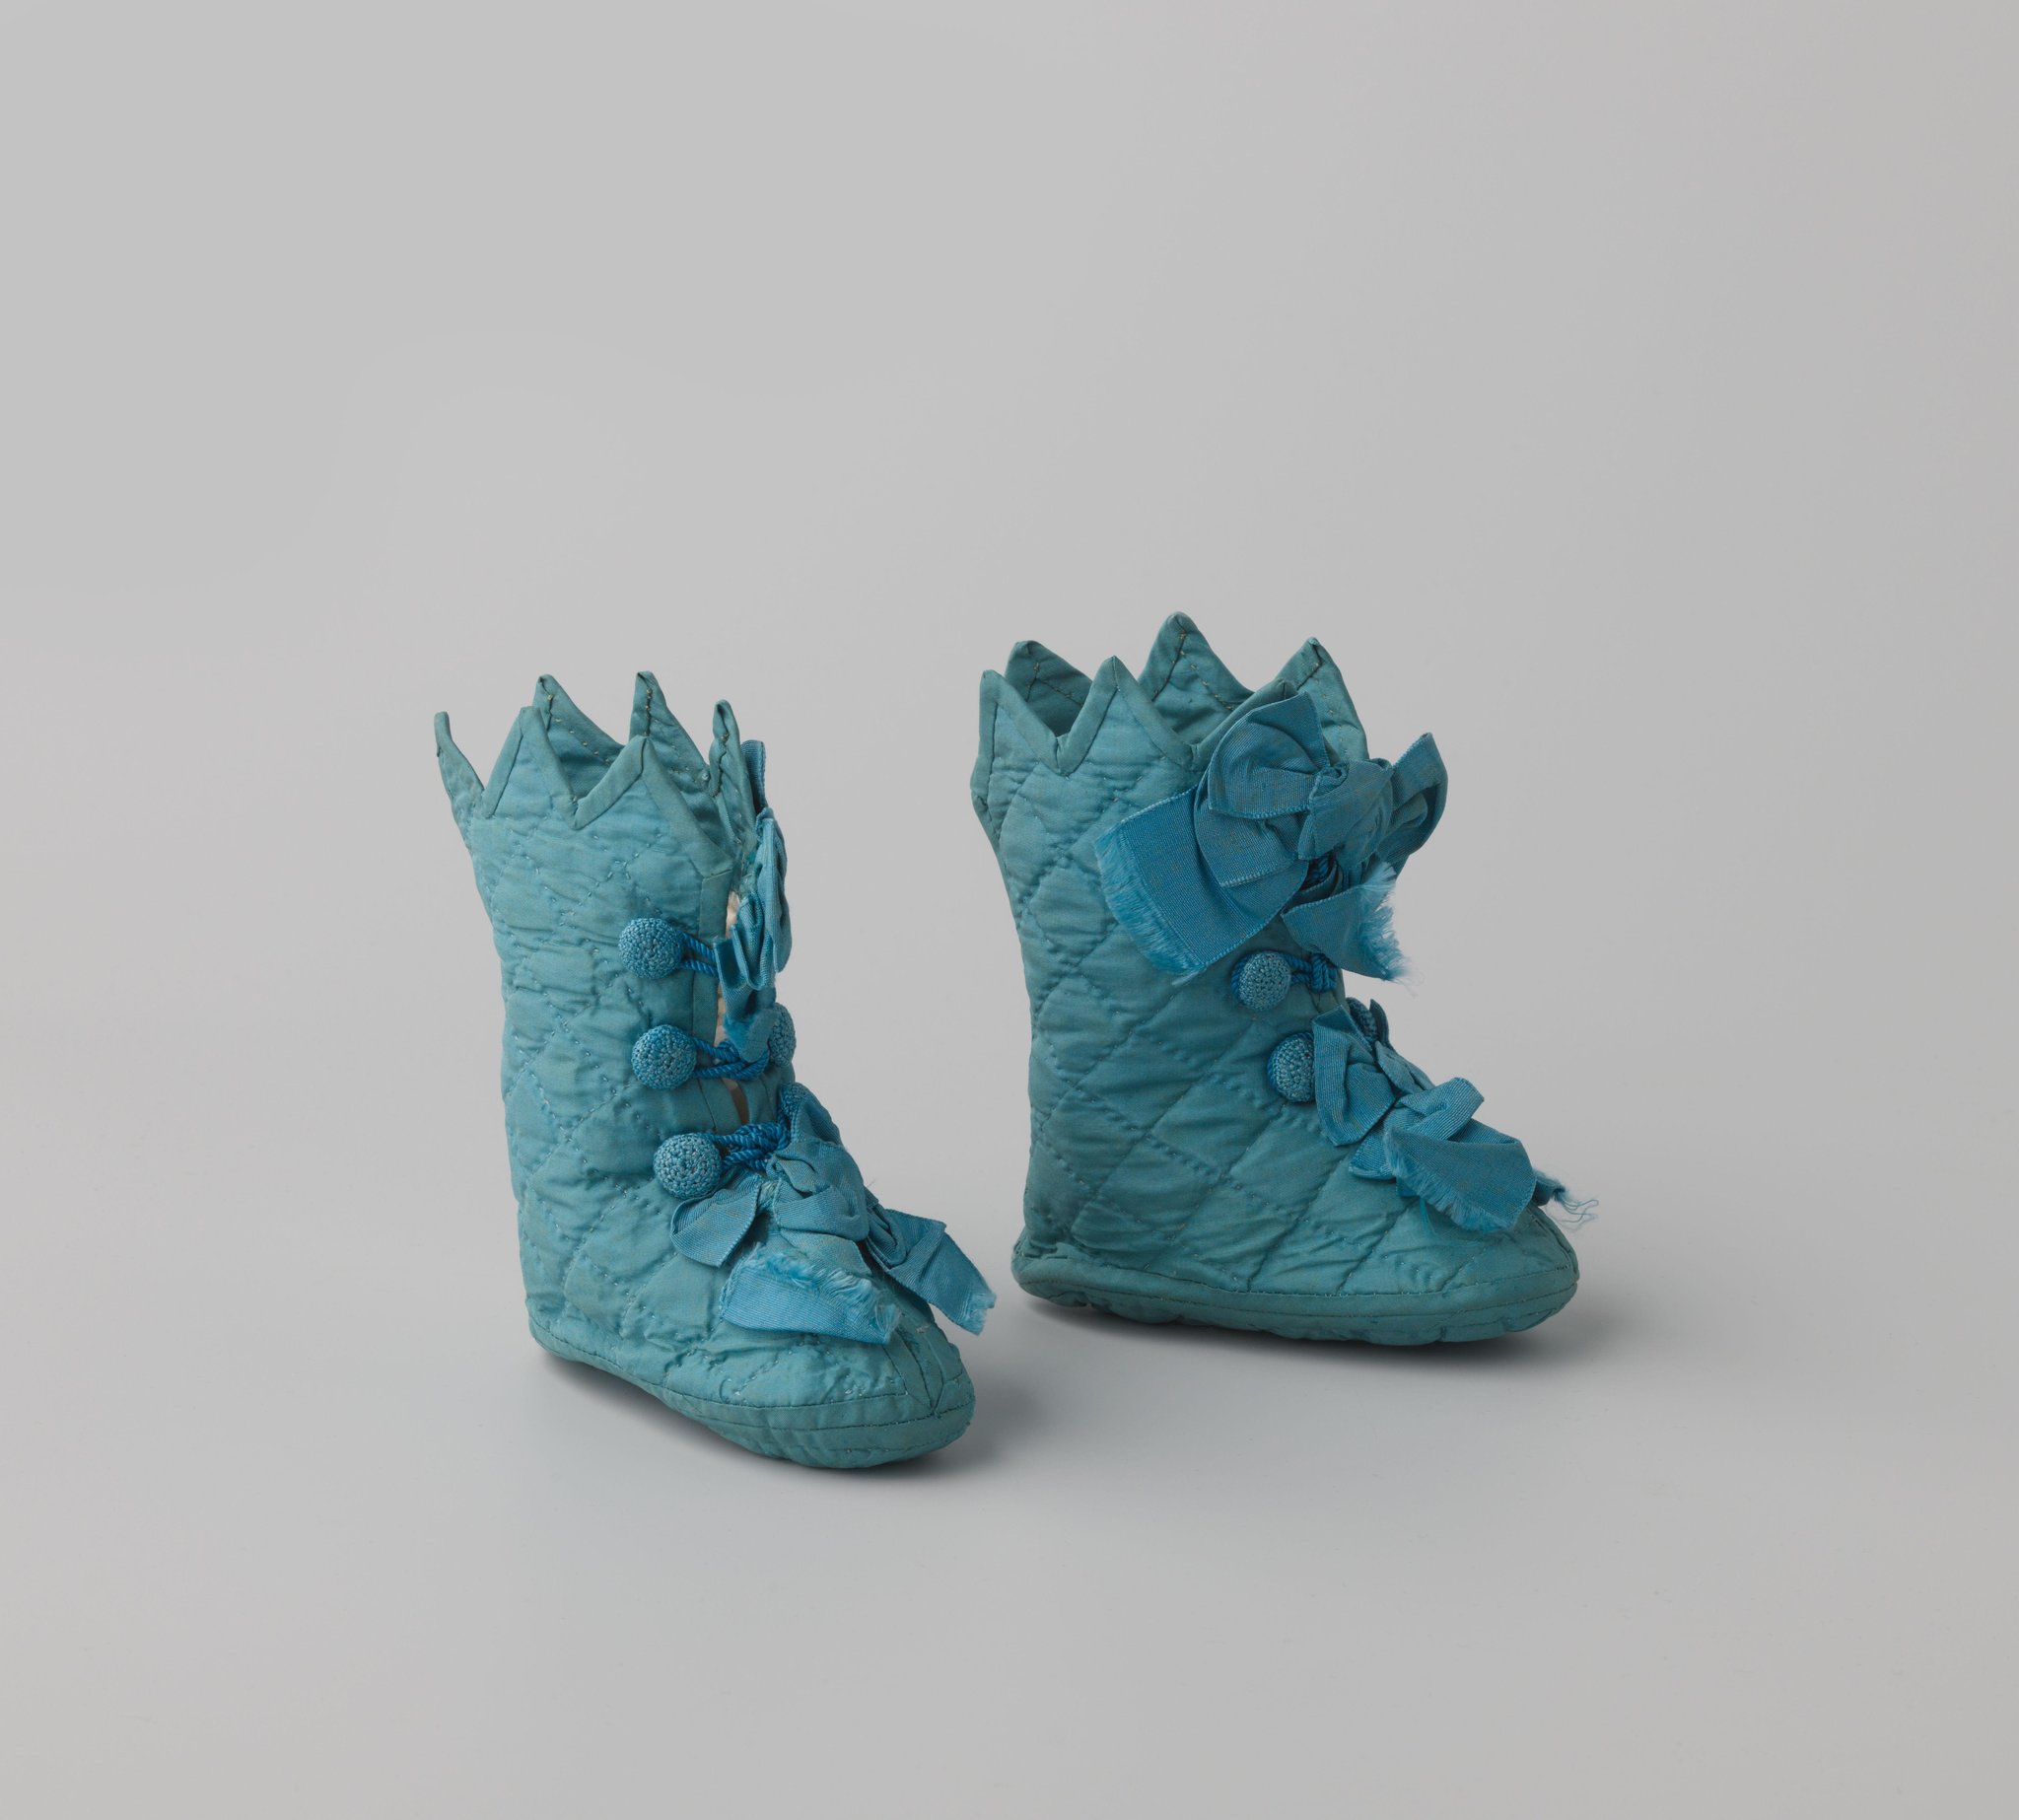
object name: shoe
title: Babyschoen van lichtblauwe zijde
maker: Anonymous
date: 1840-1850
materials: silk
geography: netherlands